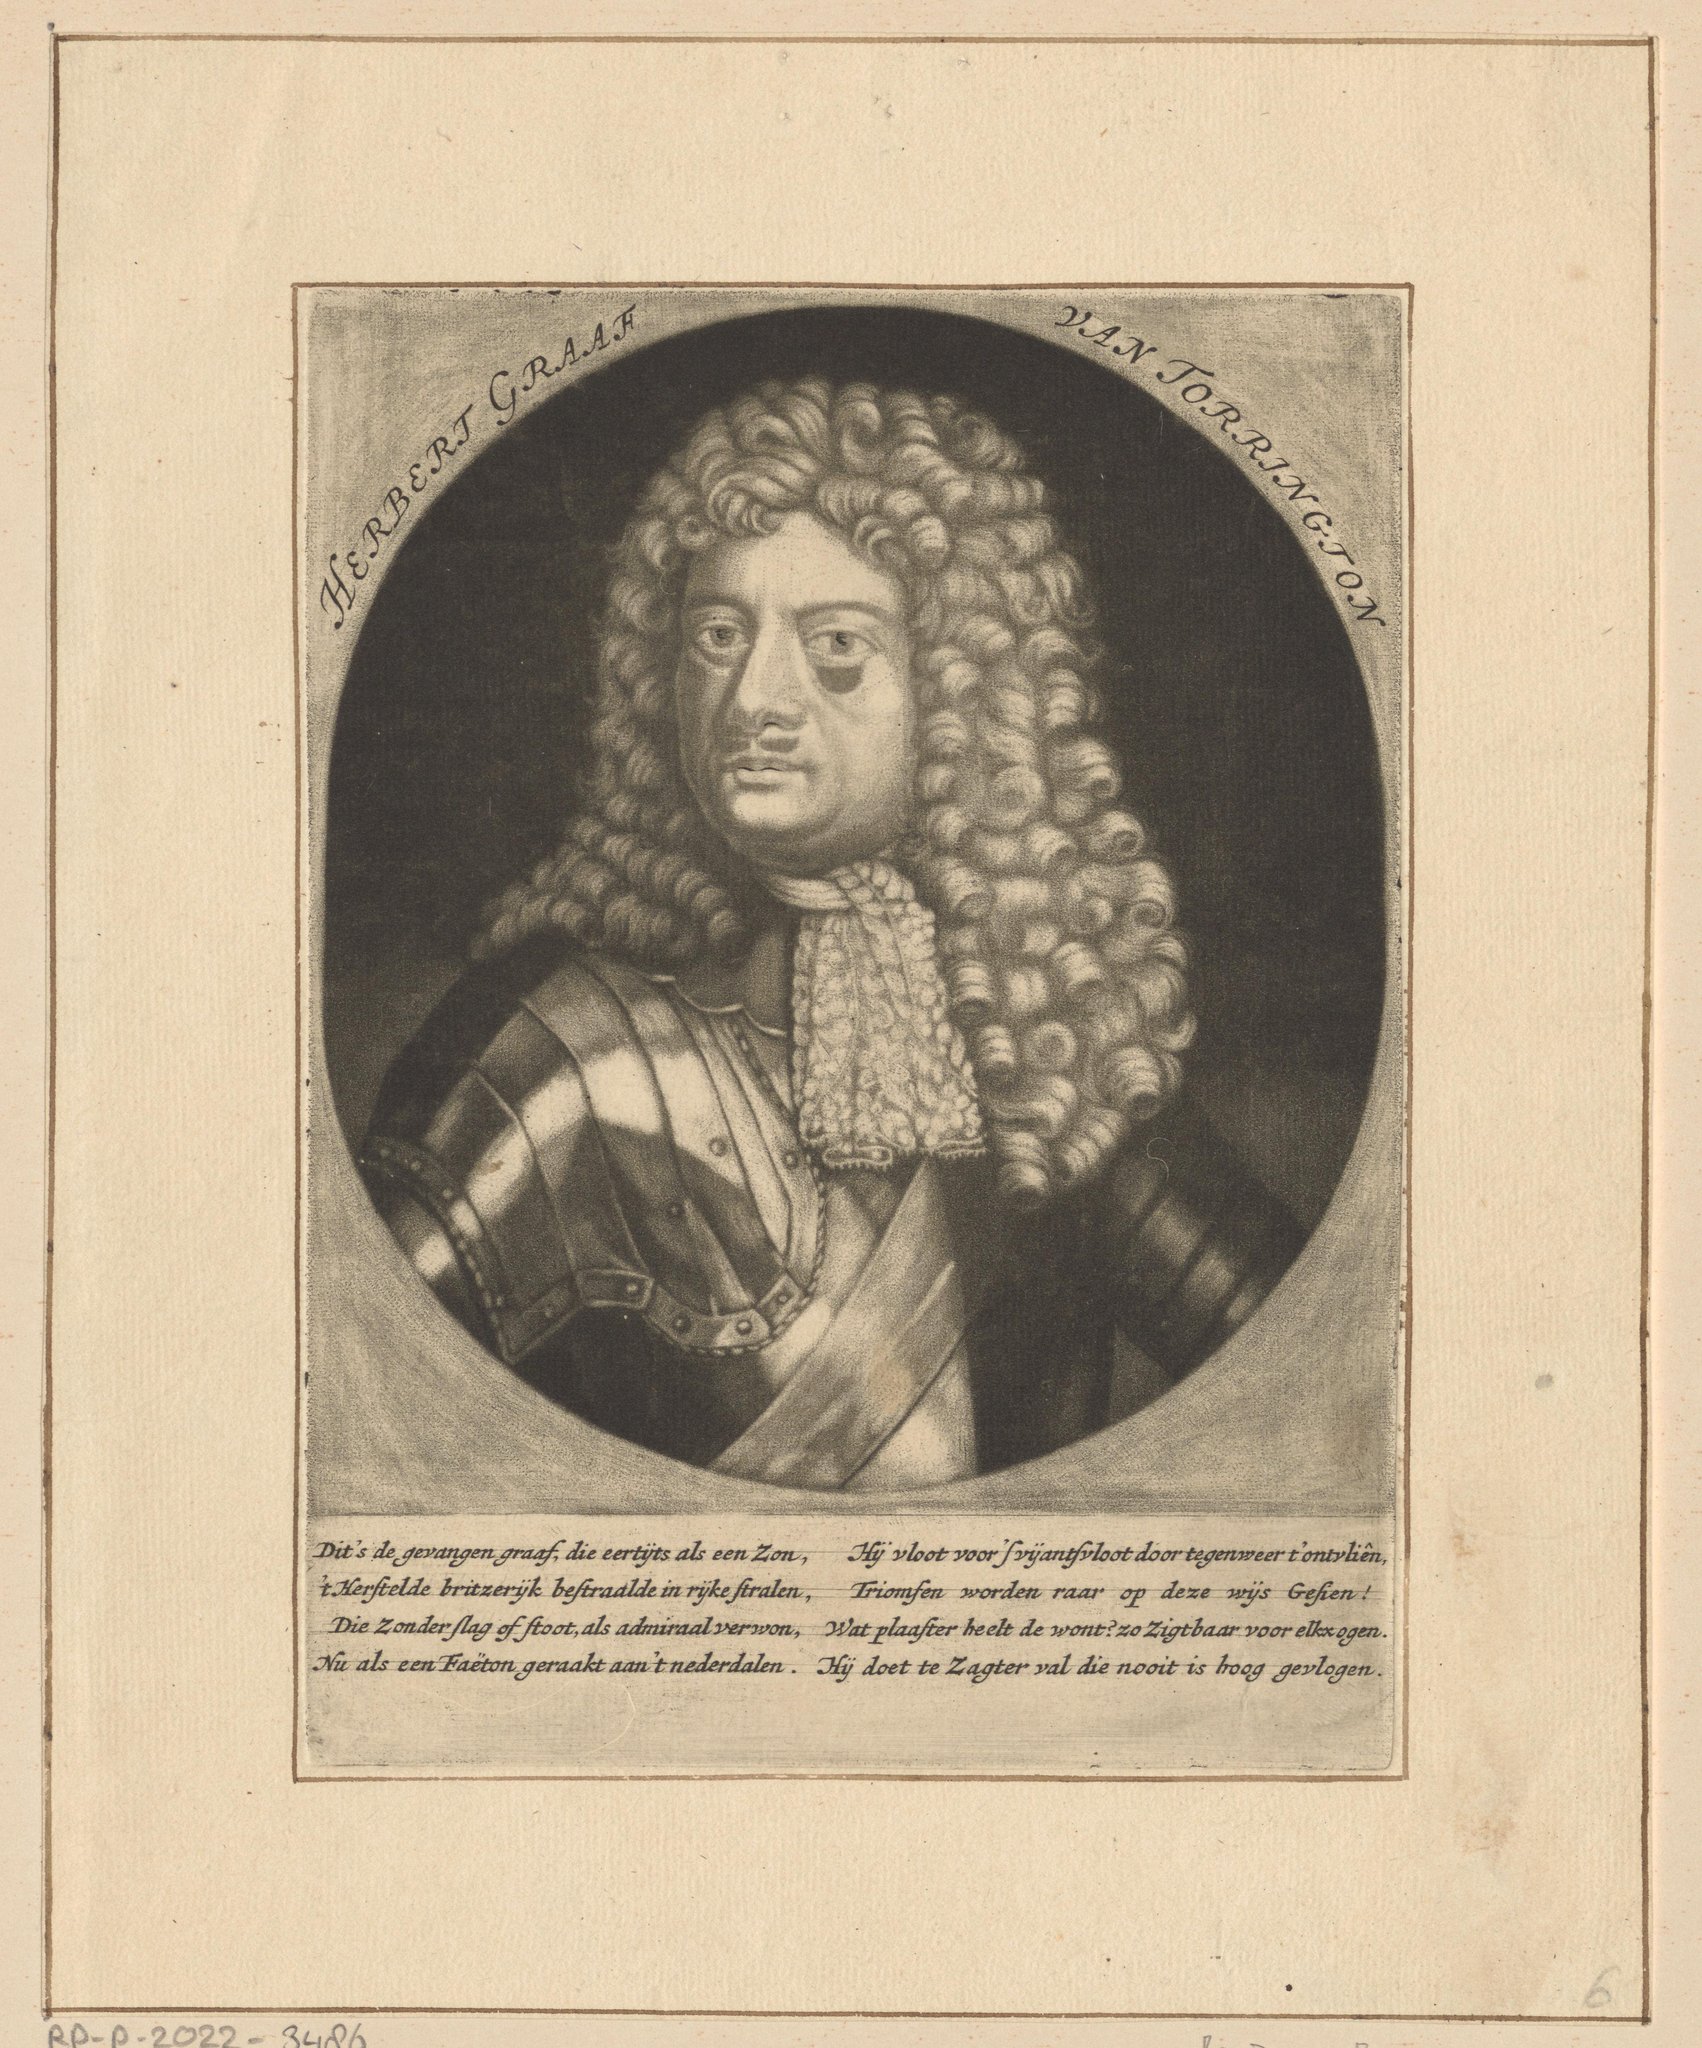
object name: print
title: Portret van Arthur Hebert, graaf van Torrington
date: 1690-1692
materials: paper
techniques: mezzotint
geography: england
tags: politician, armour, historical persons, commander-in-chief, admiral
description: Met achtregelig onderschrift in het Nederlands.